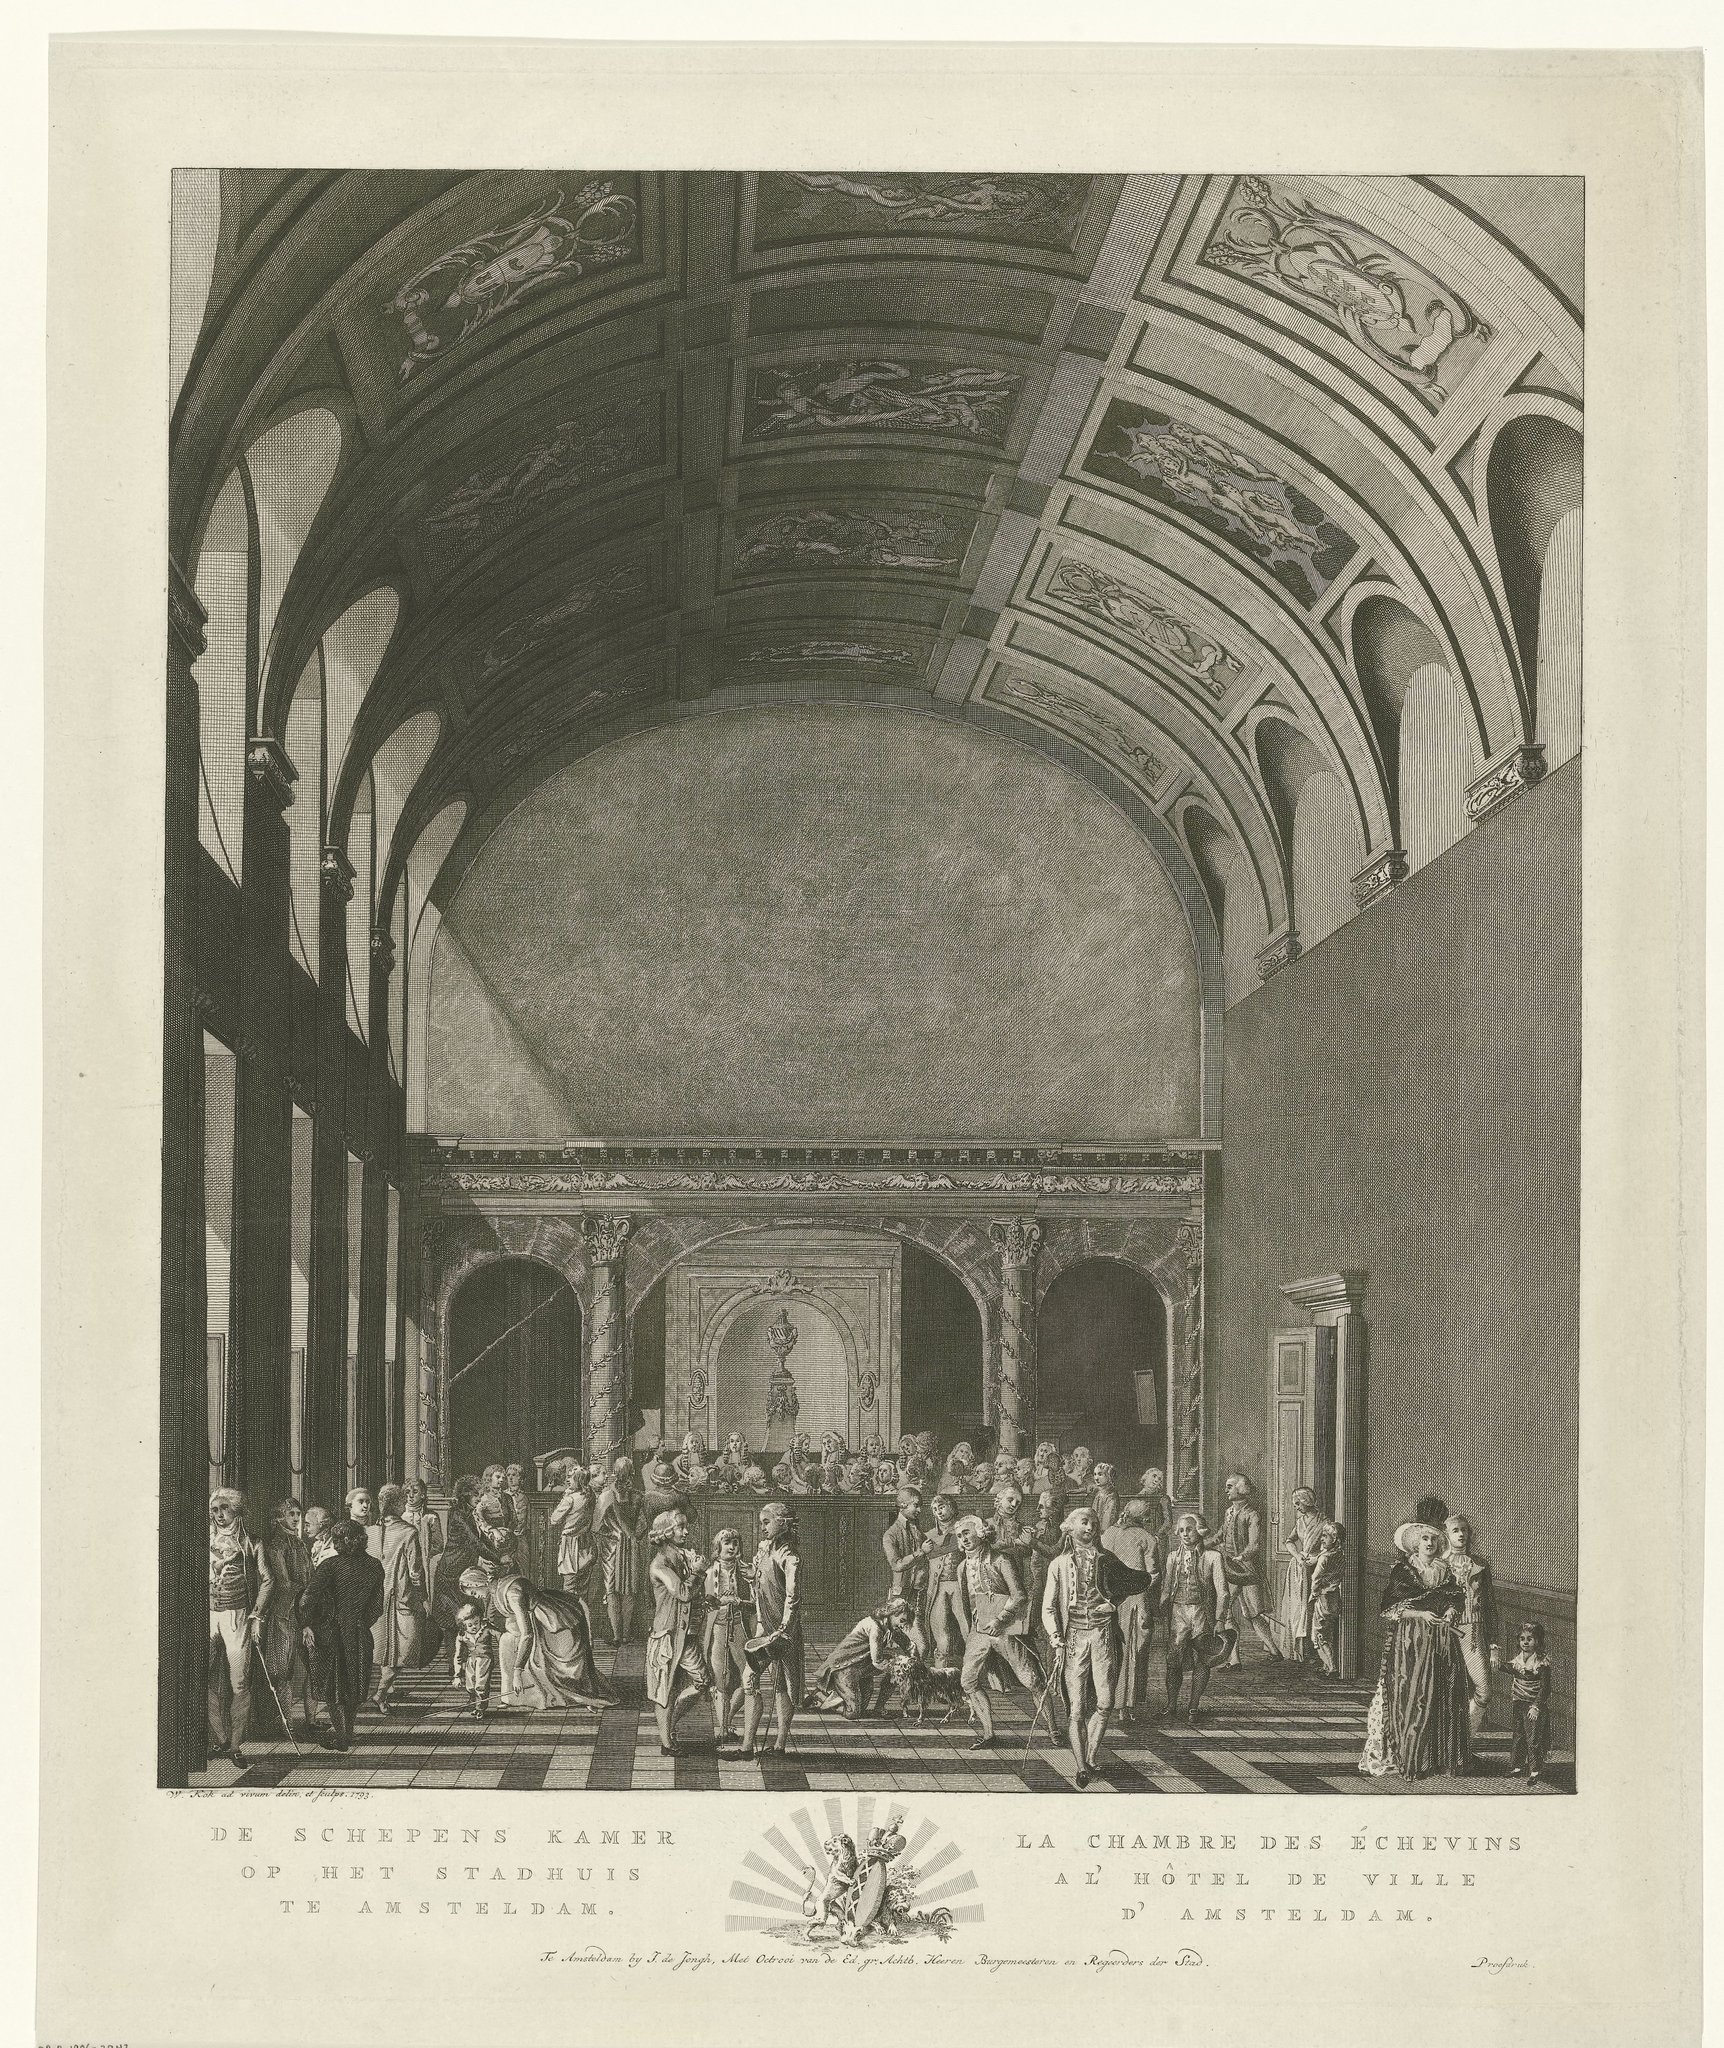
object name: print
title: Gezicht op het interieur van de Schepenzaal van het Stadhuis op de Dam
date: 1793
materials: paper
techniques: etching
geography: amsterdam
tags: dog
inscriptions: collector's mark: Lugt 2228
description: In de Schepenzaal van het Stadhuis op de Dam bevinden zich verschillende figuren, voornamelijk mannen. De schepenen zitten in de banken. Enkele figuren zijn met elkaar in gesprek en anderen lijken het interieur te bewonderen. Op het plafon zijn de familiewapens van de eerste schepenen te zien. Onder de afbeelding een drieregelig onderschrift, links in het Frans en rechts in het Nederlands. In het midden van de tekst het gekroonde wapen van Amsterdam, vastgehouden door de Nederlandse leeuw.